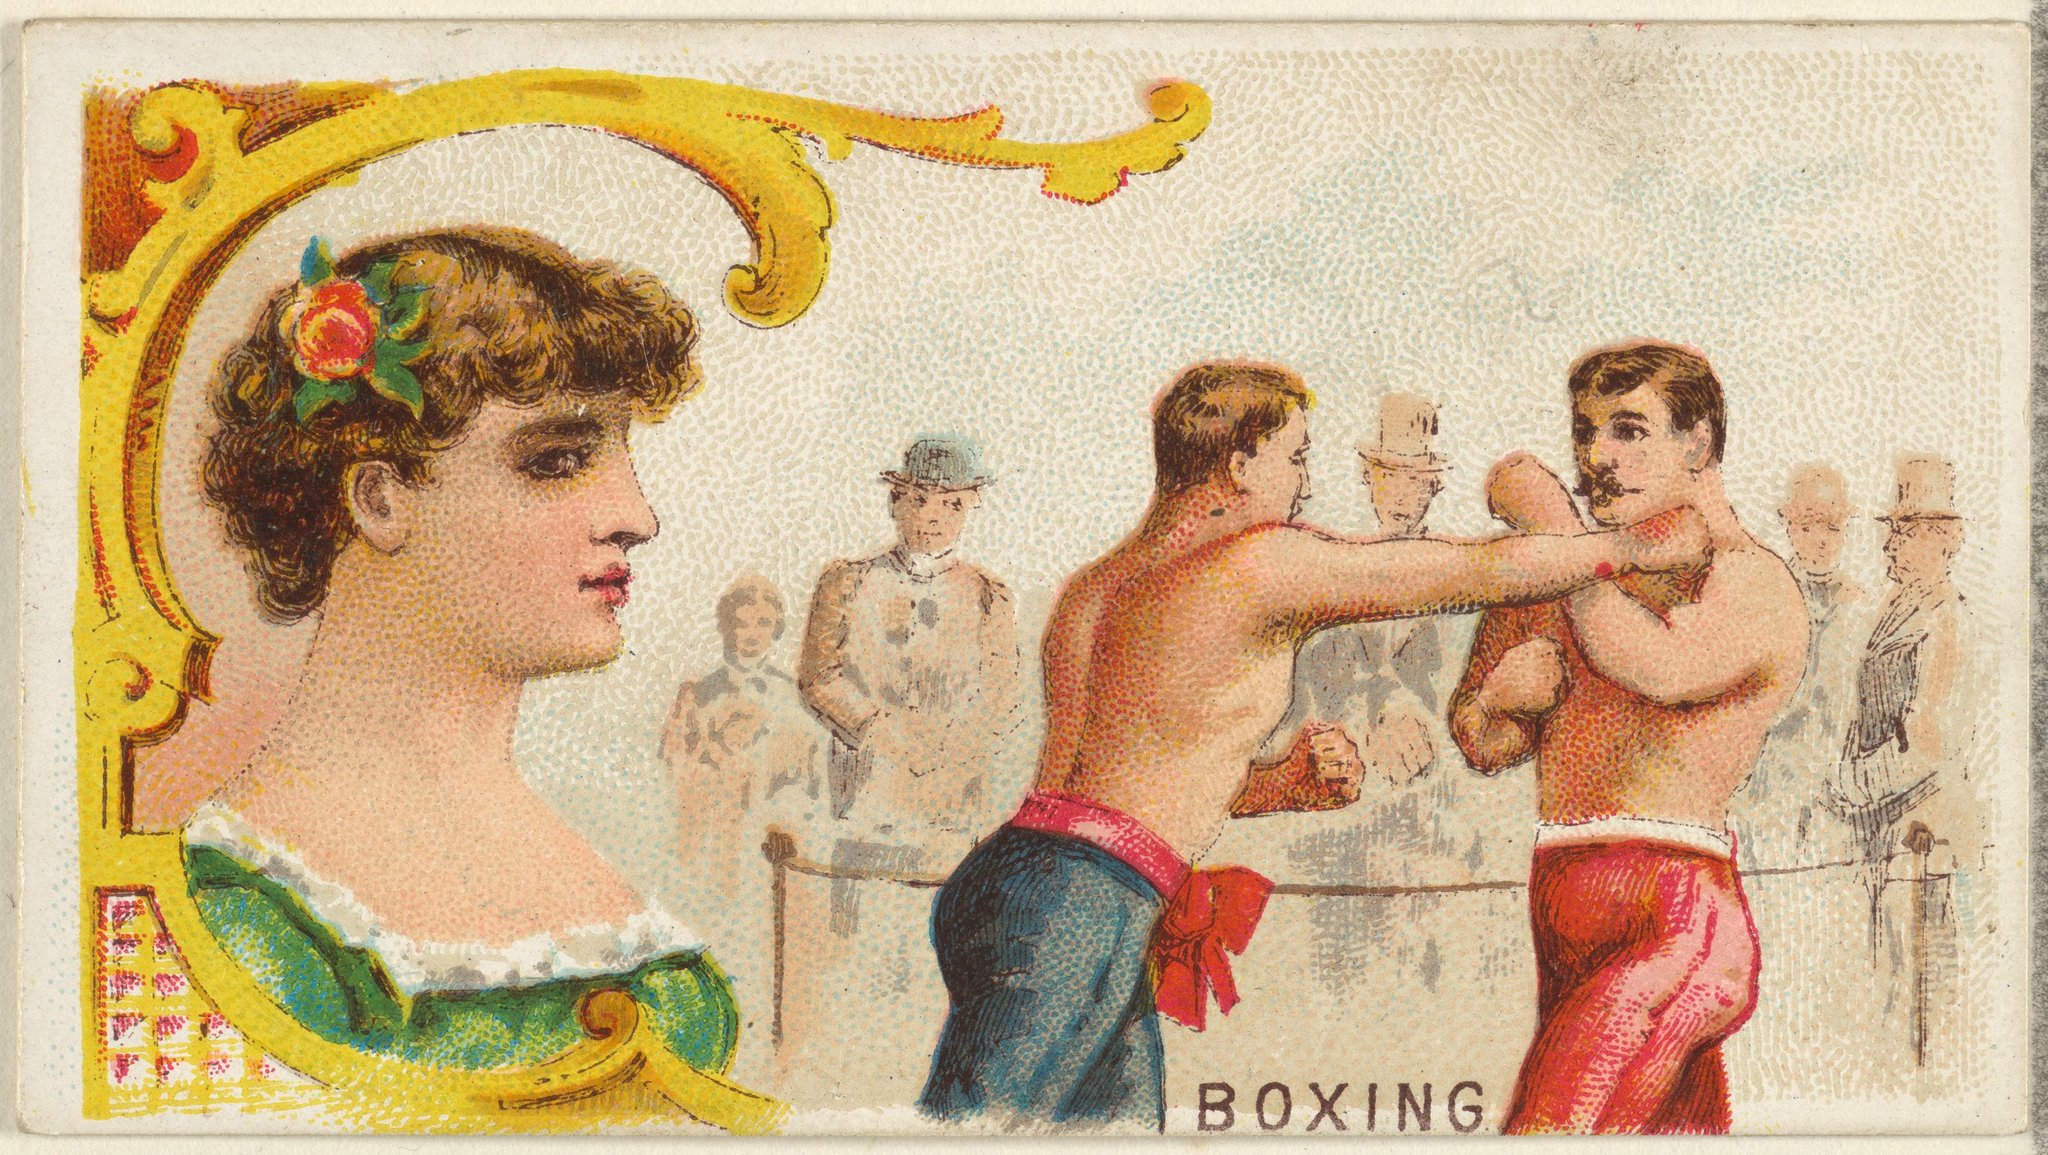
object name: print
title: Boxing, from the Games and Sports series (N165) for Old Judge Cigarettes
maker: goodwin & company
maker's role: publisher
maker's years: 1850-1950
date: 1889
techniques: color lithograph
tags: men,women,boxing,athletes